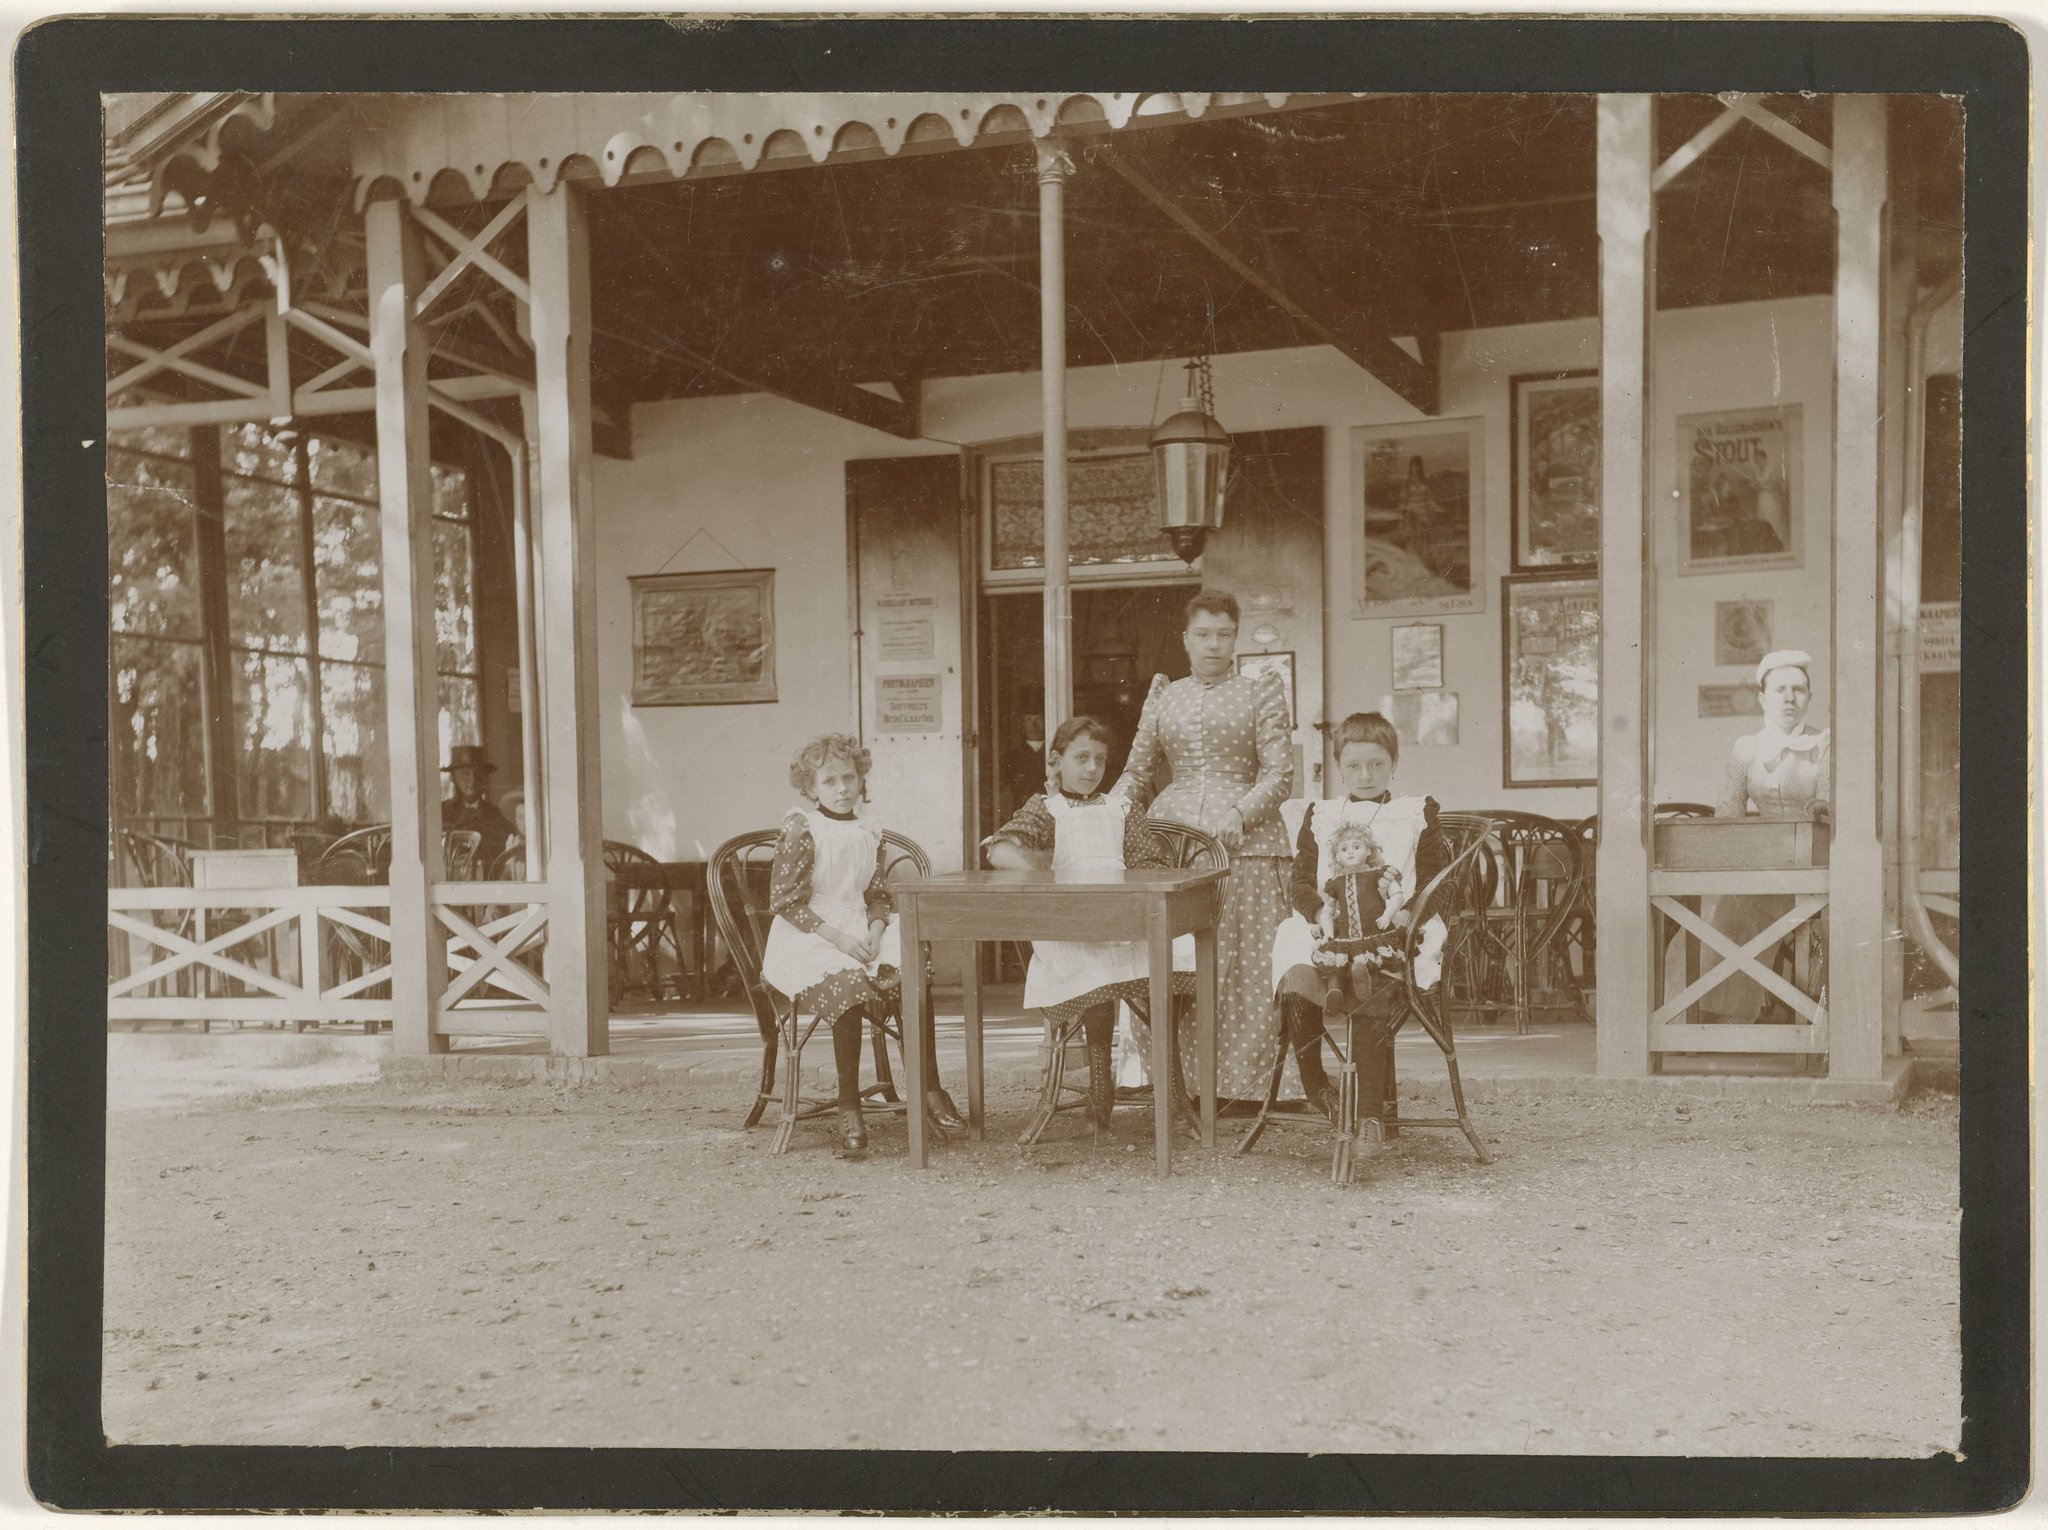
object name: photograph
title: Drie meisjes en een jonge vrouw bij uitspanning Westerbouwing in Oosterbeek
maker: Anonymous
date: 1885-1900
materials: cardboard, photographic support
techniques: collodion silver print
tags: oosterbeek, westerbouwing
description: Drie meisjes en een jonge vrouw bij uitspanning Westerbouwing bij Wageningen.